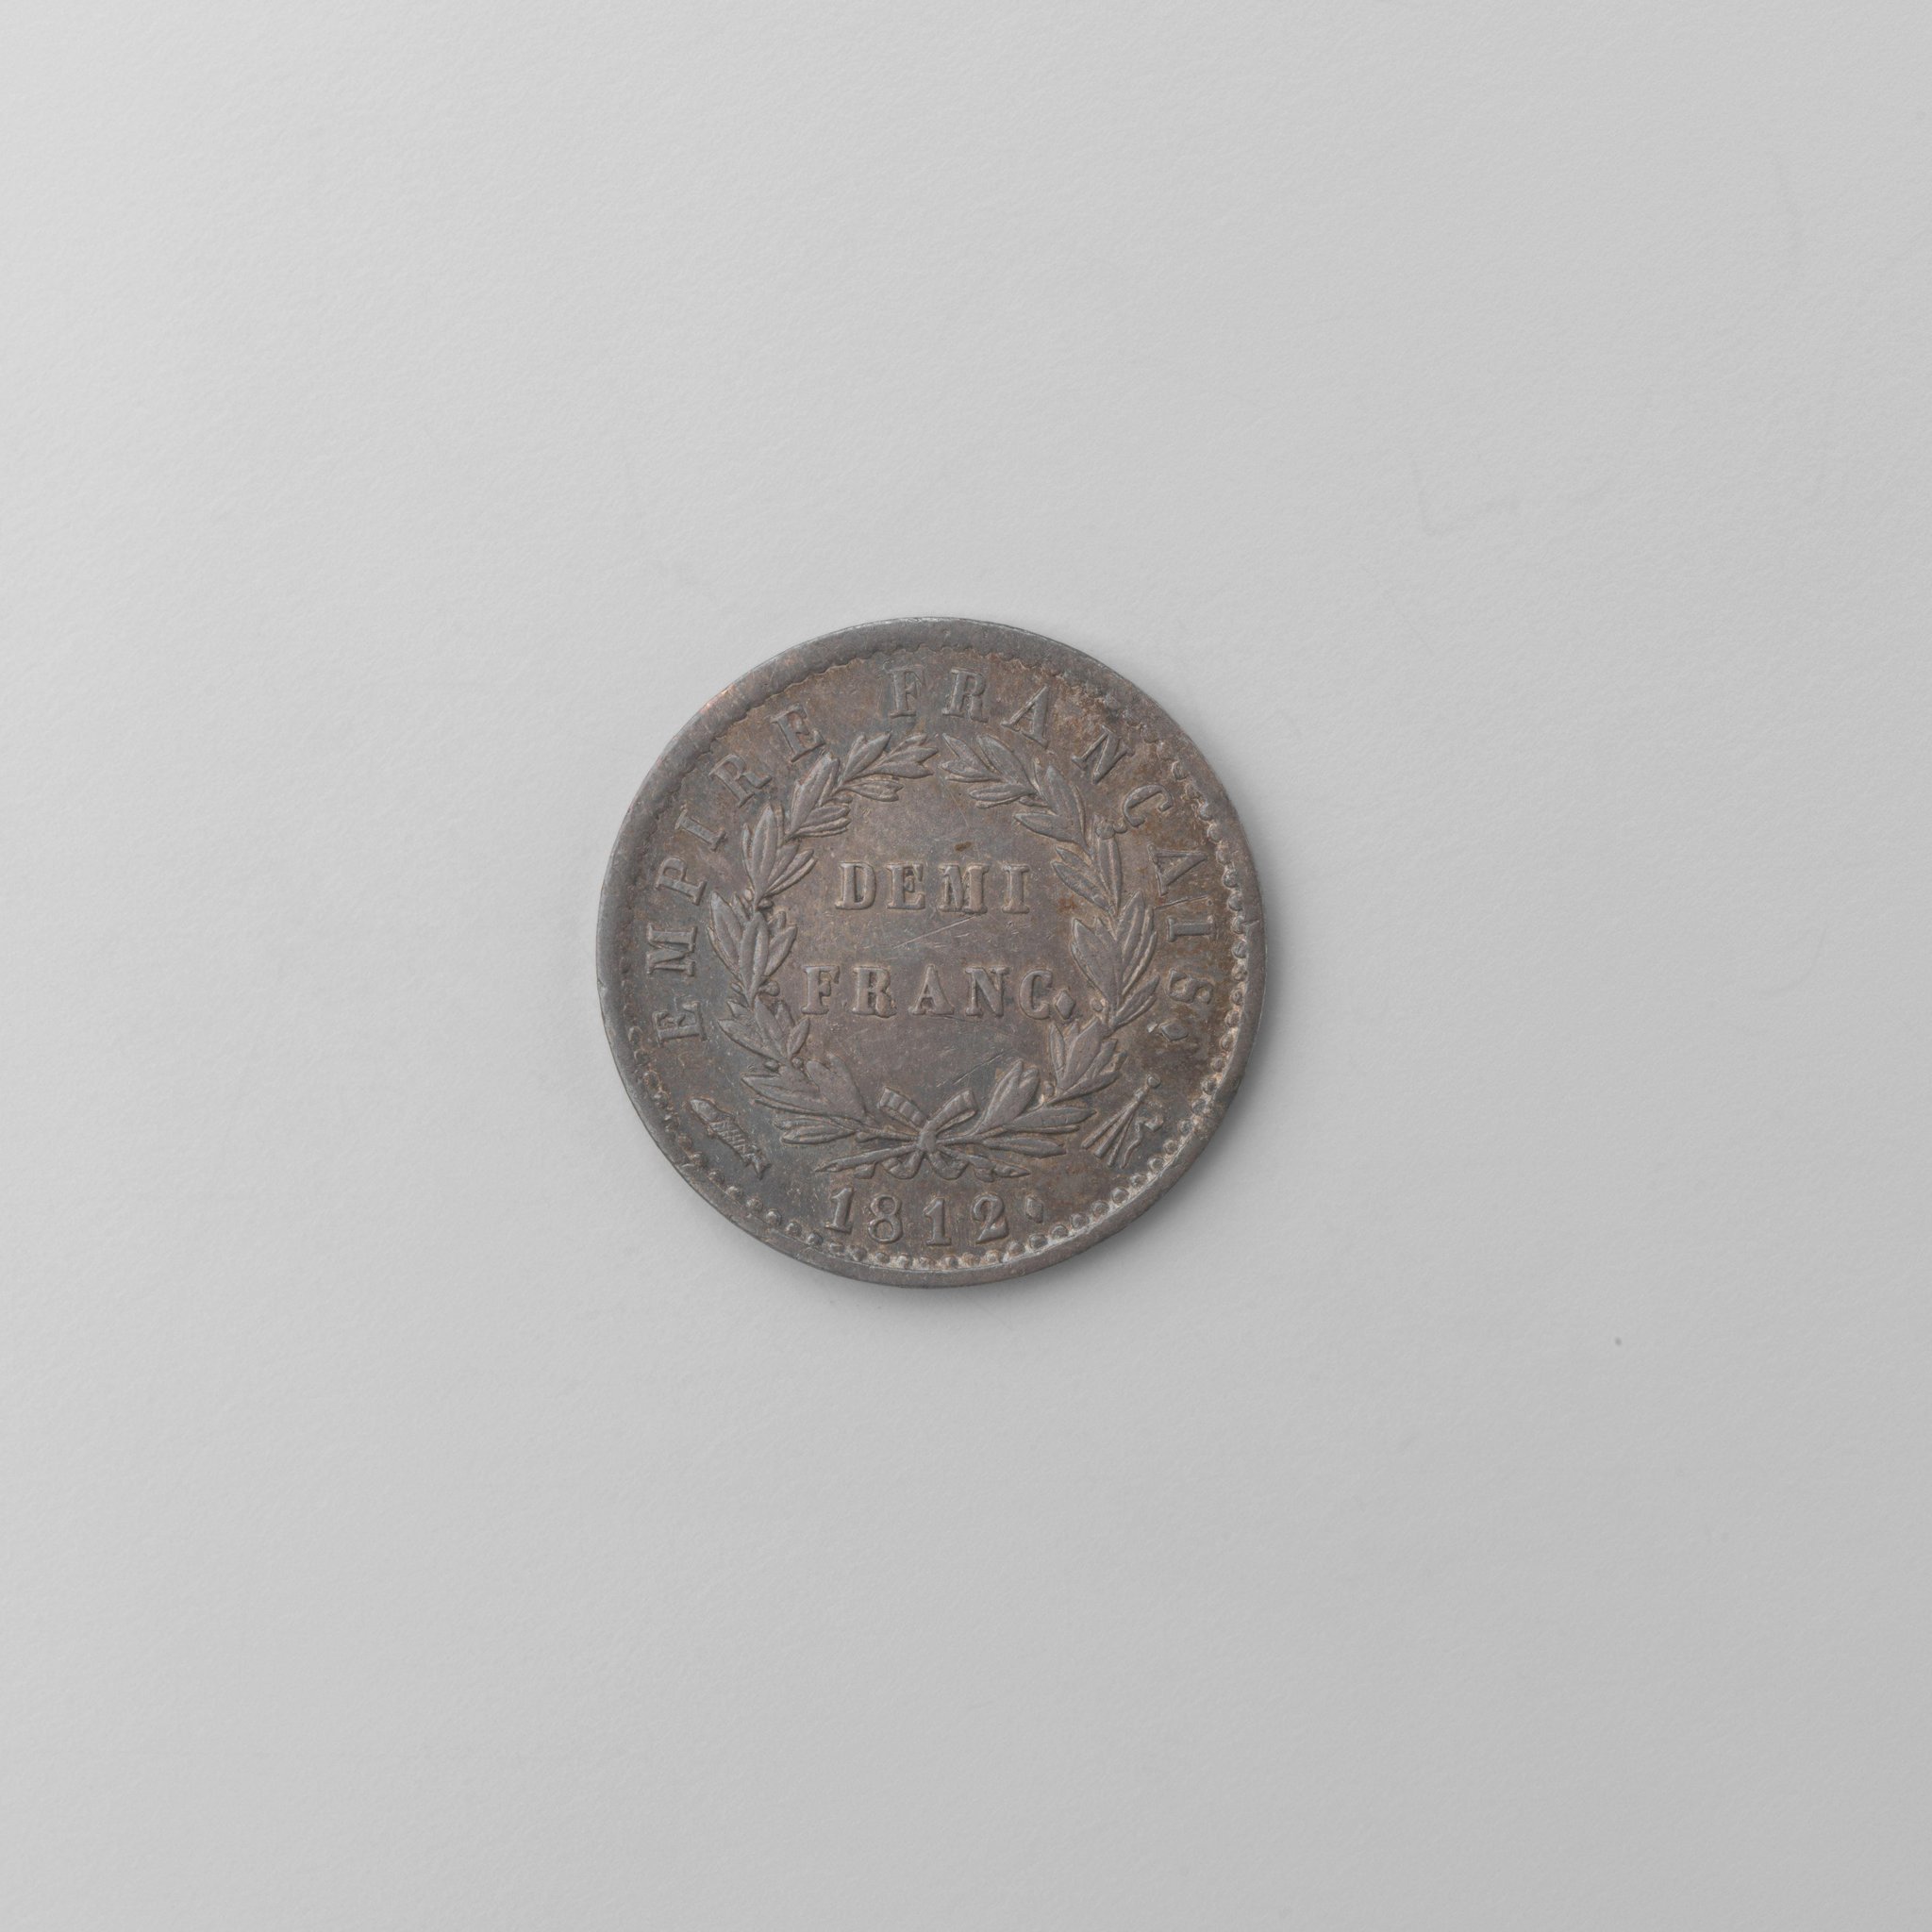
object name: coin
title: Nederland, bij Frankrijk ingelijfd, ½ franc, 1812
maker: napoleon i (emperor of the french)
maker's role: generaal, keizer, staatsman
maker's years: 1769-1821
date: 1812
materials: silver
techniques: striking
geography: utrecht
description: Zilveren munt. Voorzijde: gelauwerd borstbeeld van Napoleon I naar rechts. Keerzijde: binnen olijfkrans waarde-aanduiding demi franc. Jaartal in omschrift onderaan. Gladde rand.